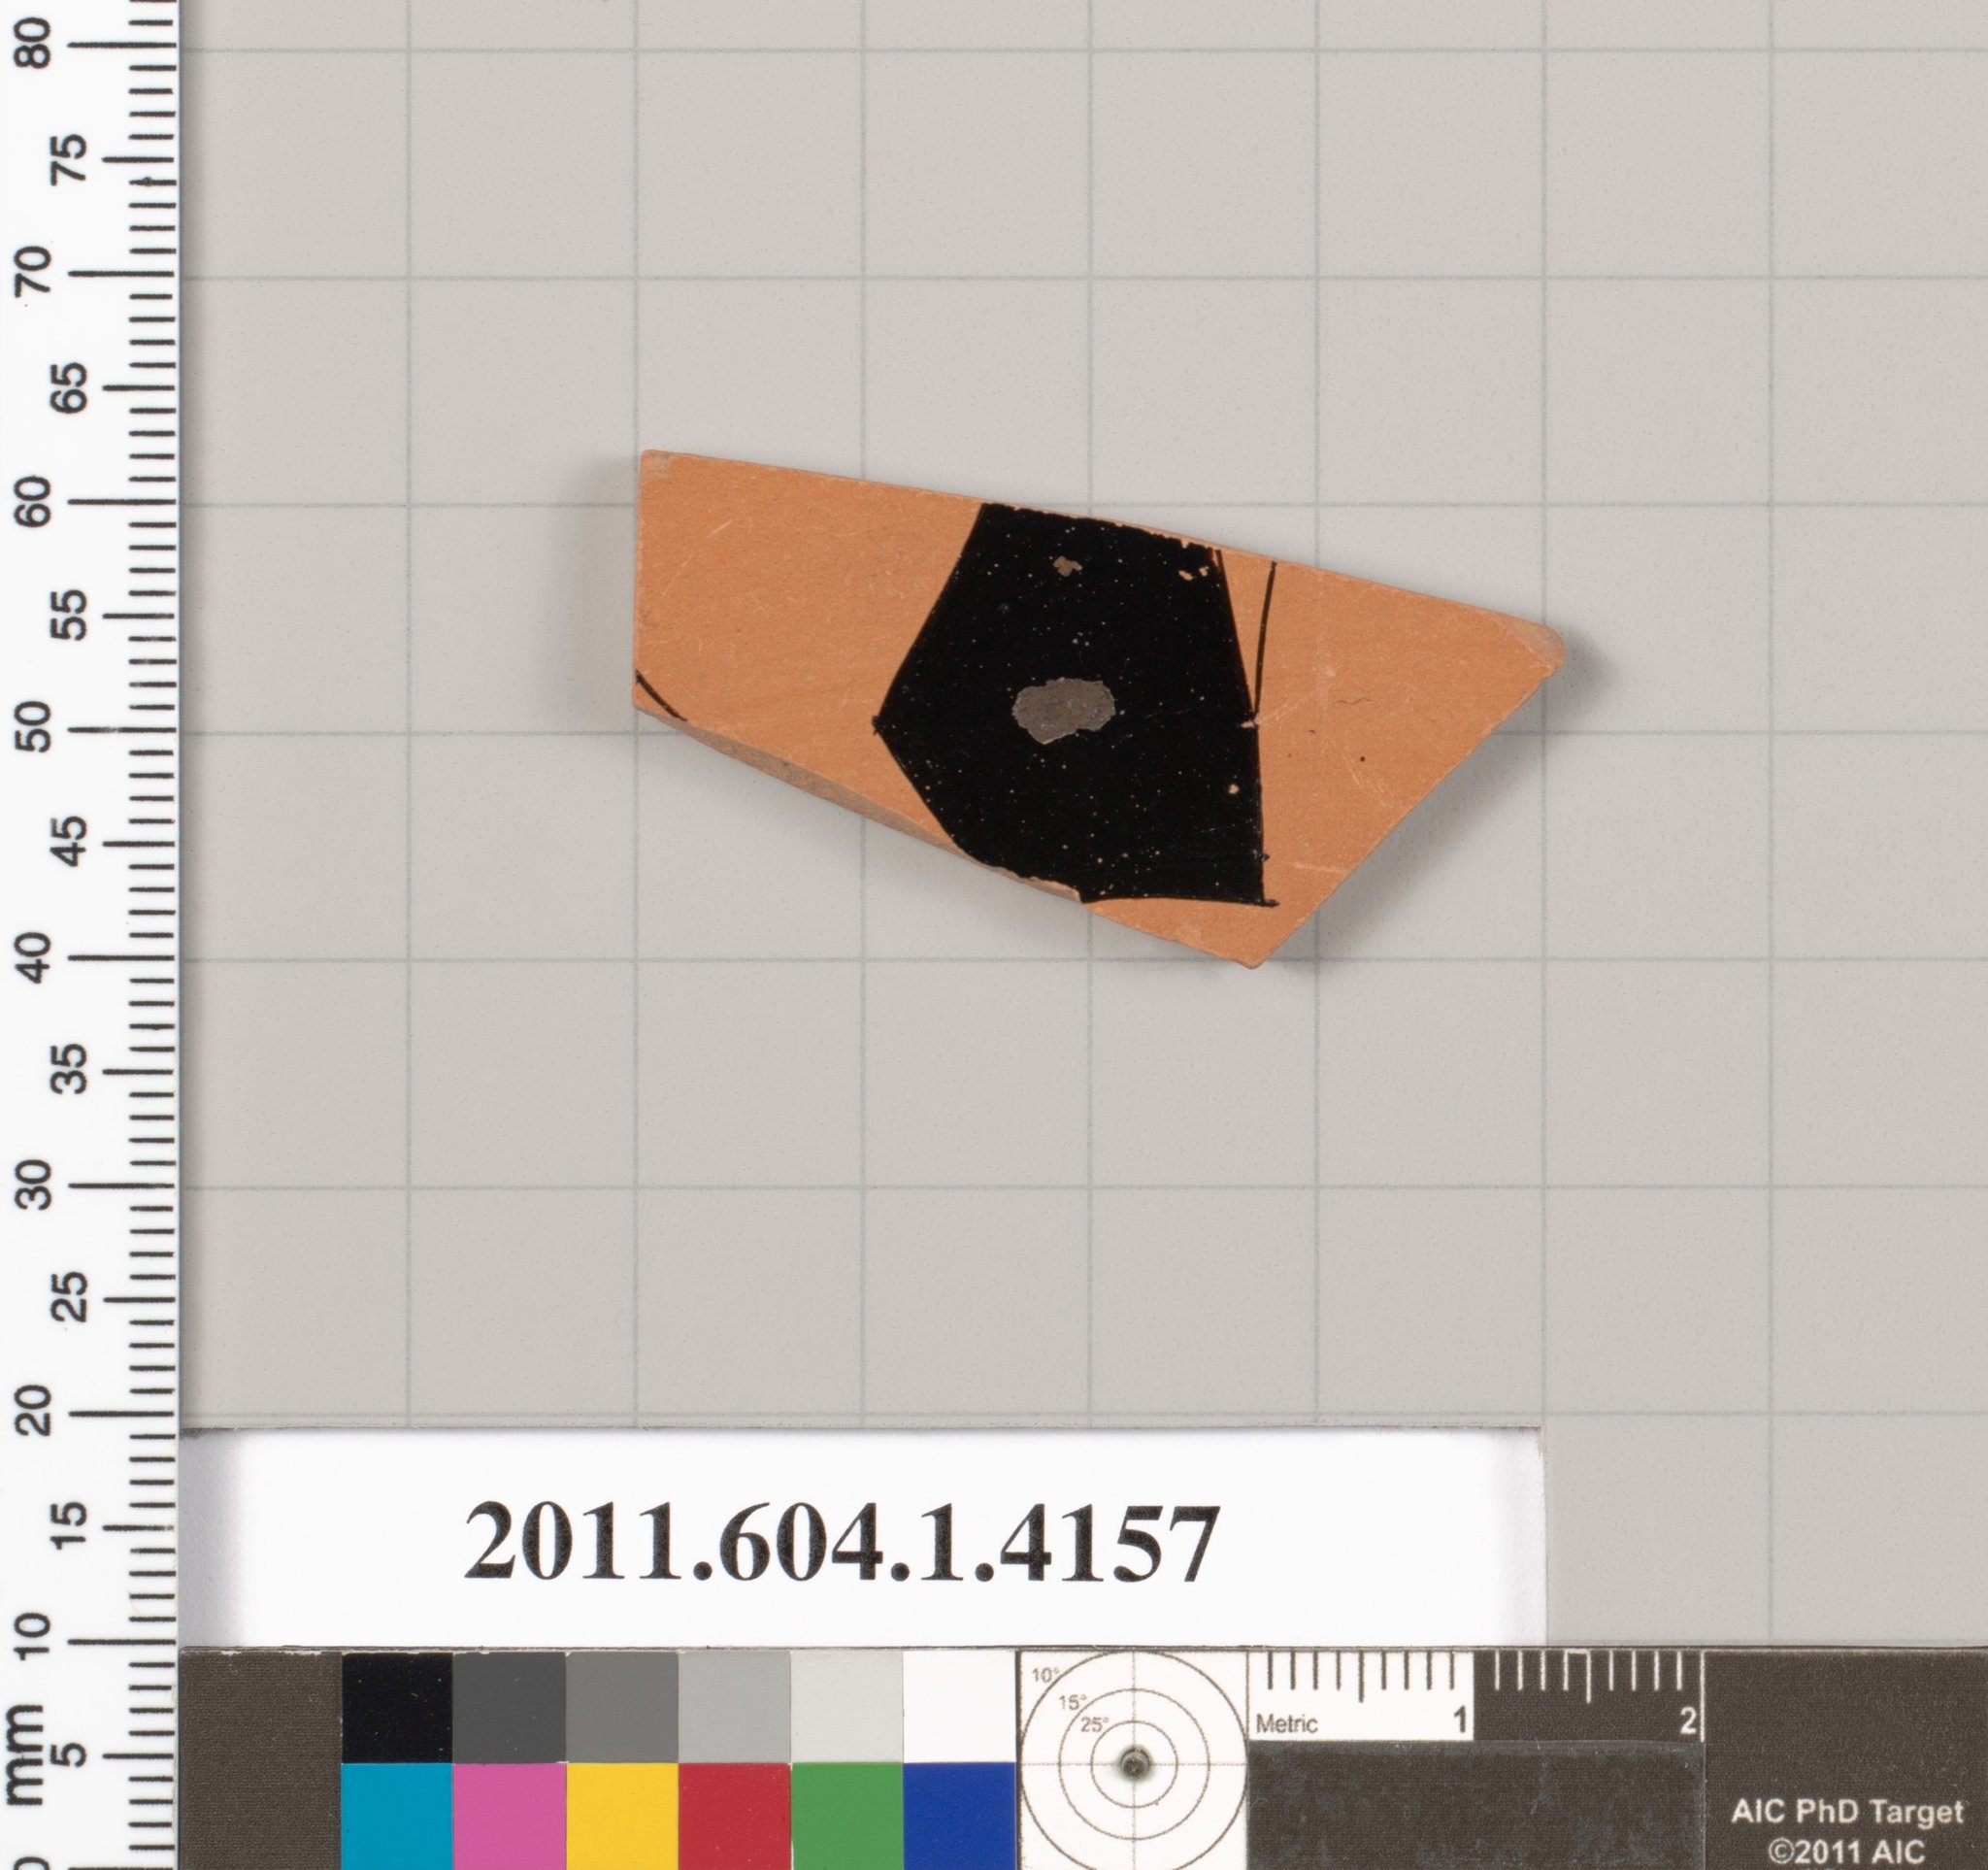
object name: kylix fragment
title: Terracotta fragment of a kylix (drinking cup)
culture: greek, attic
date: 490-470 BCE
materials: terracotta